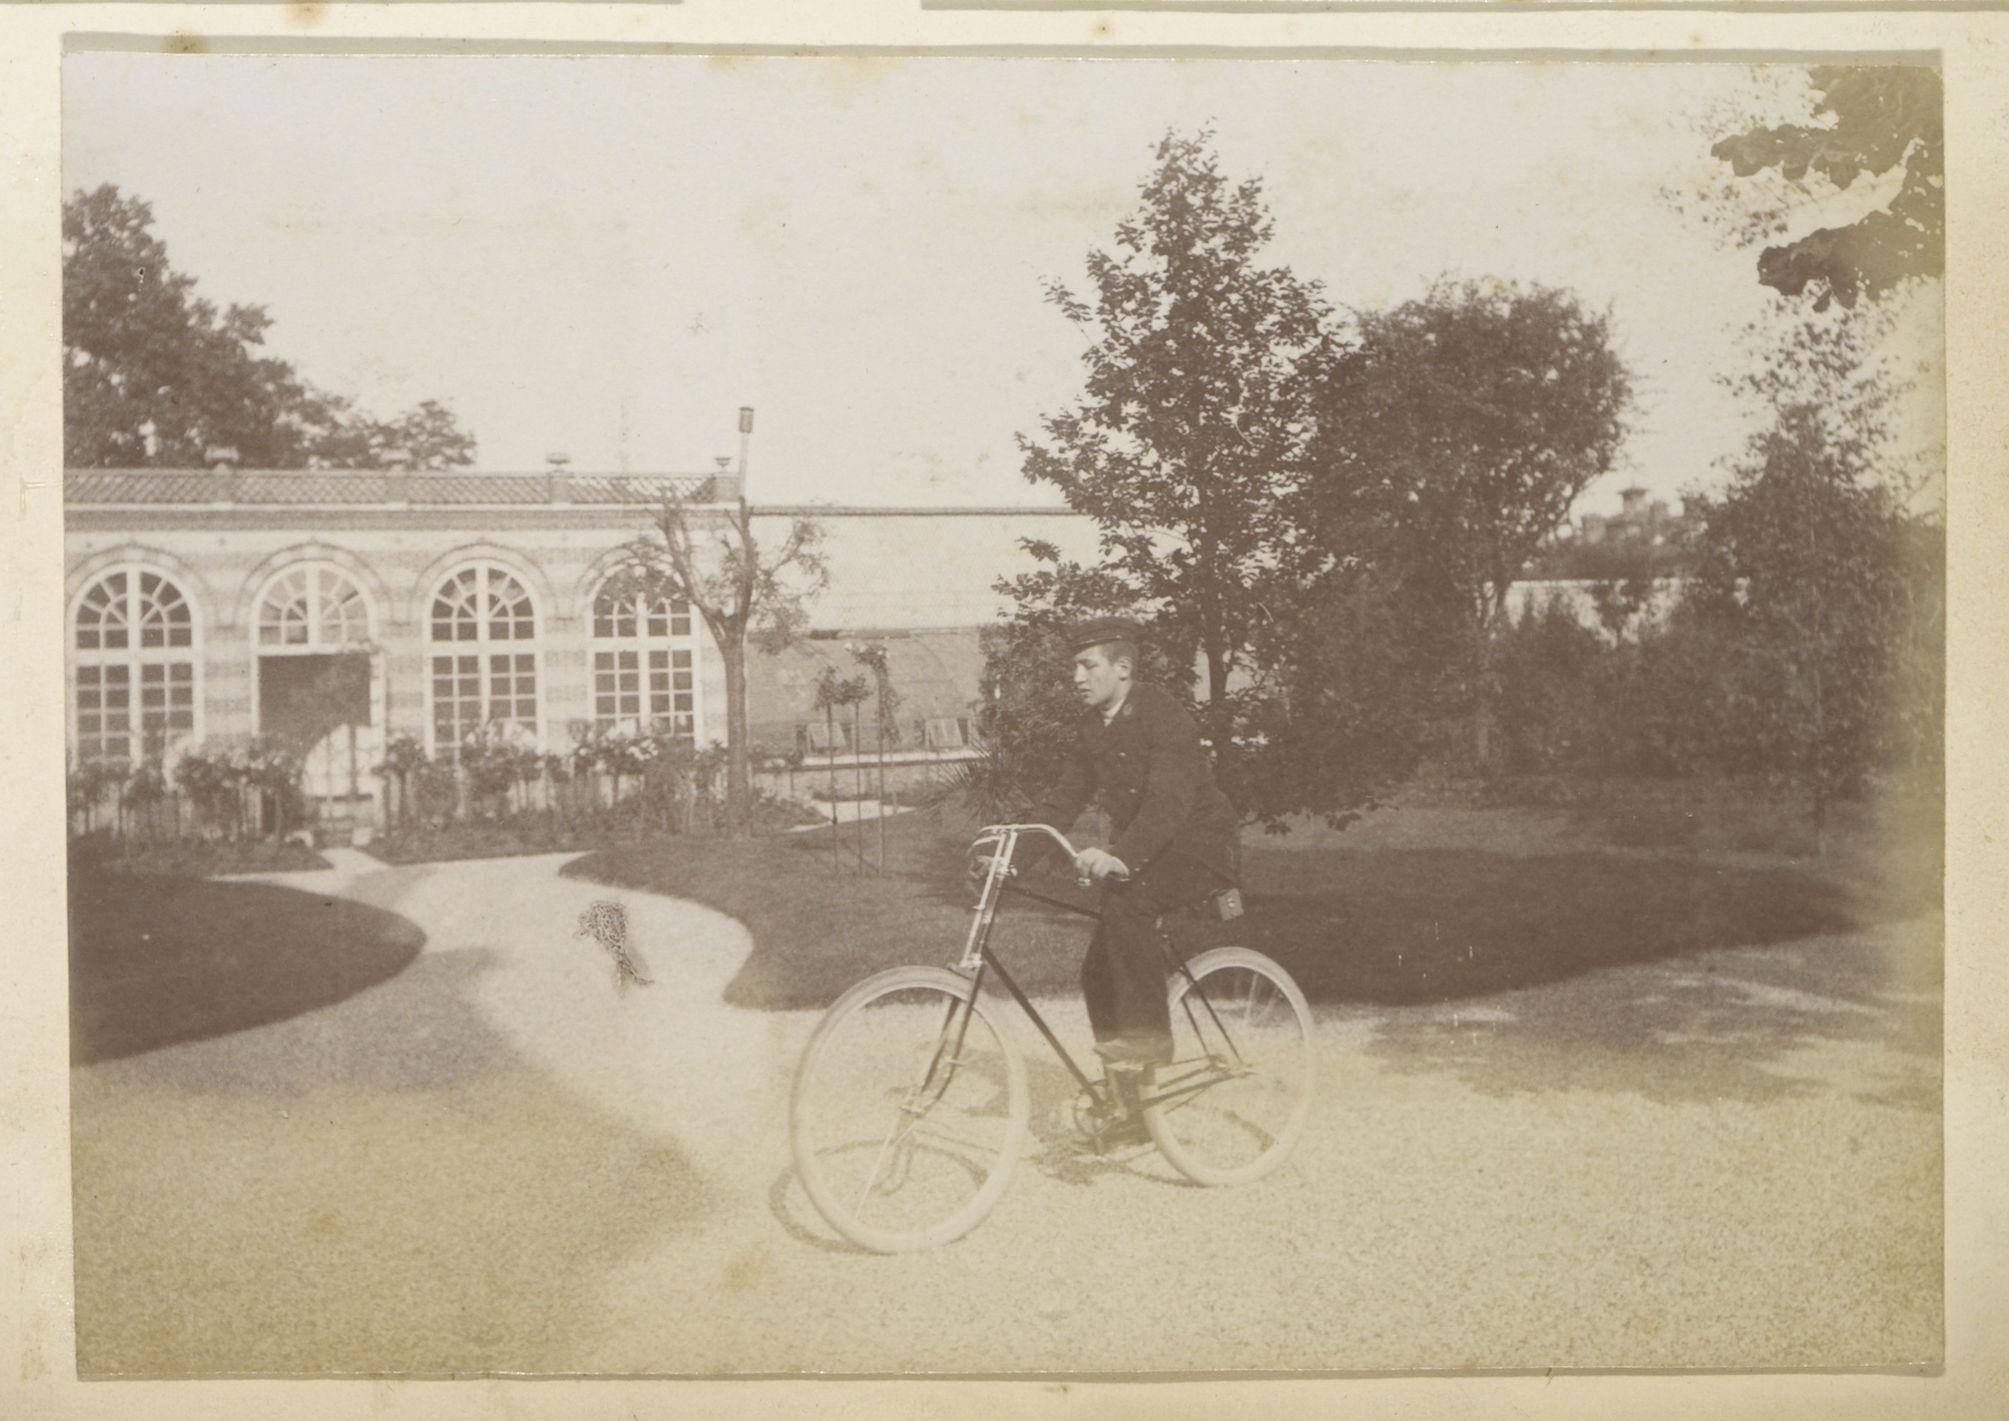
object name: photograph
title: Man op een tuinpad bij een oranjerie in Frankrijk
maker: Anonymous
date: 1900-1910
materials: paper, photographic support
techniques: albumen print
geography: france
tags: riding, cycling (recreation), adult man, bicycle, greenhouse, orangery, france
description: Onderdeel van Fotoalbum van een Franse amateurfotograaf met opnames van een familie, distilleerderij Delizy & Doistau Fils, het leger en bezienswaardigheden in Frankrijk.